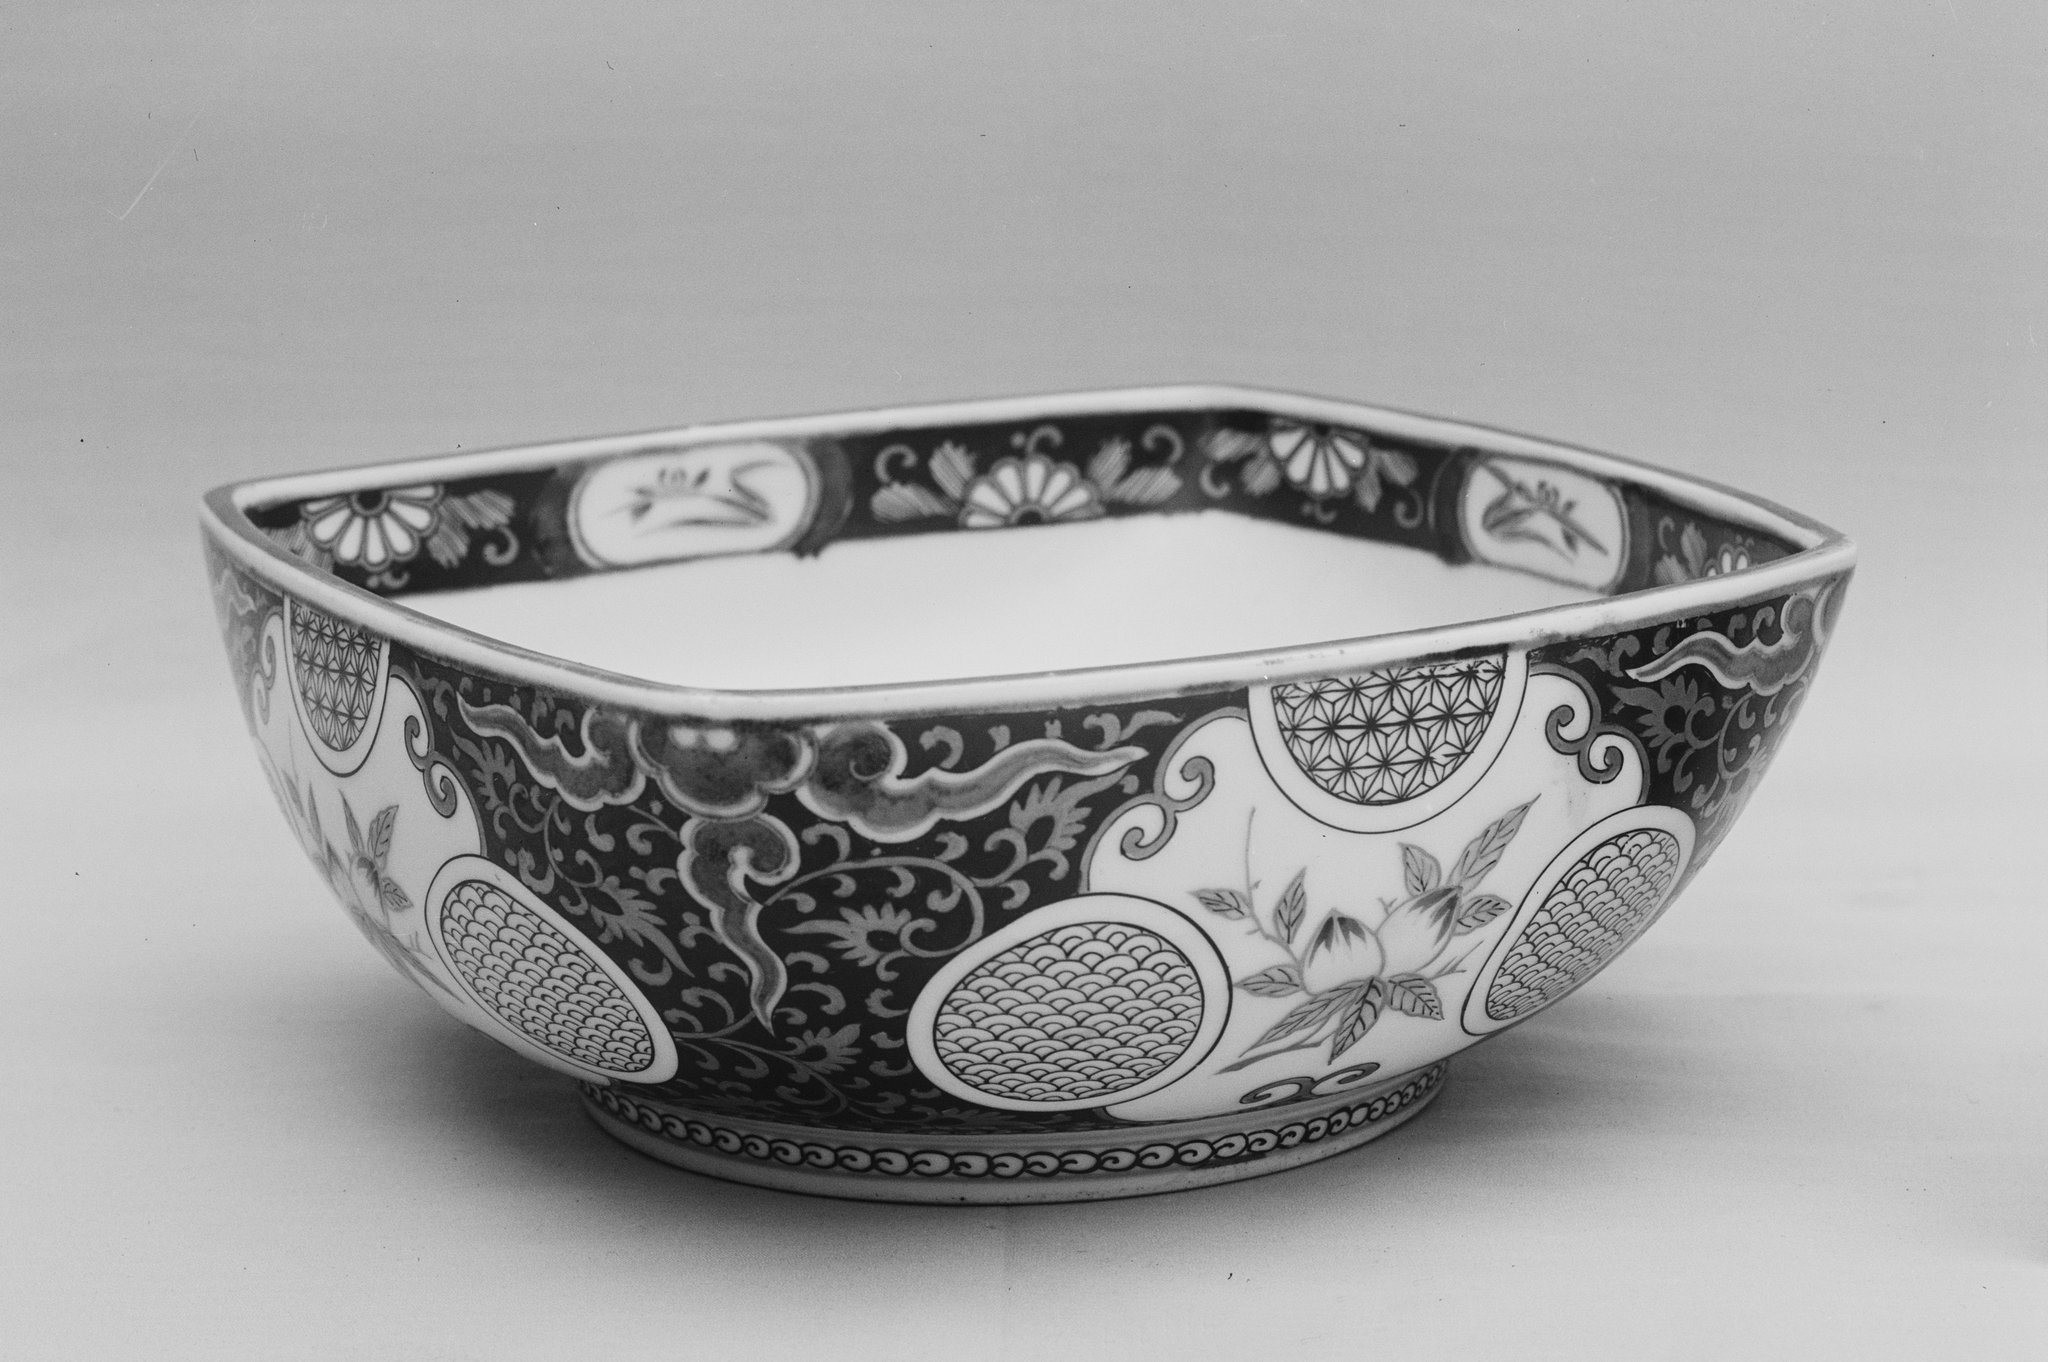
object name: bowl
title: Square Bowl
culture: japanese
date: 1760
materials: enamel, glaze, porcelain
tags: flowers